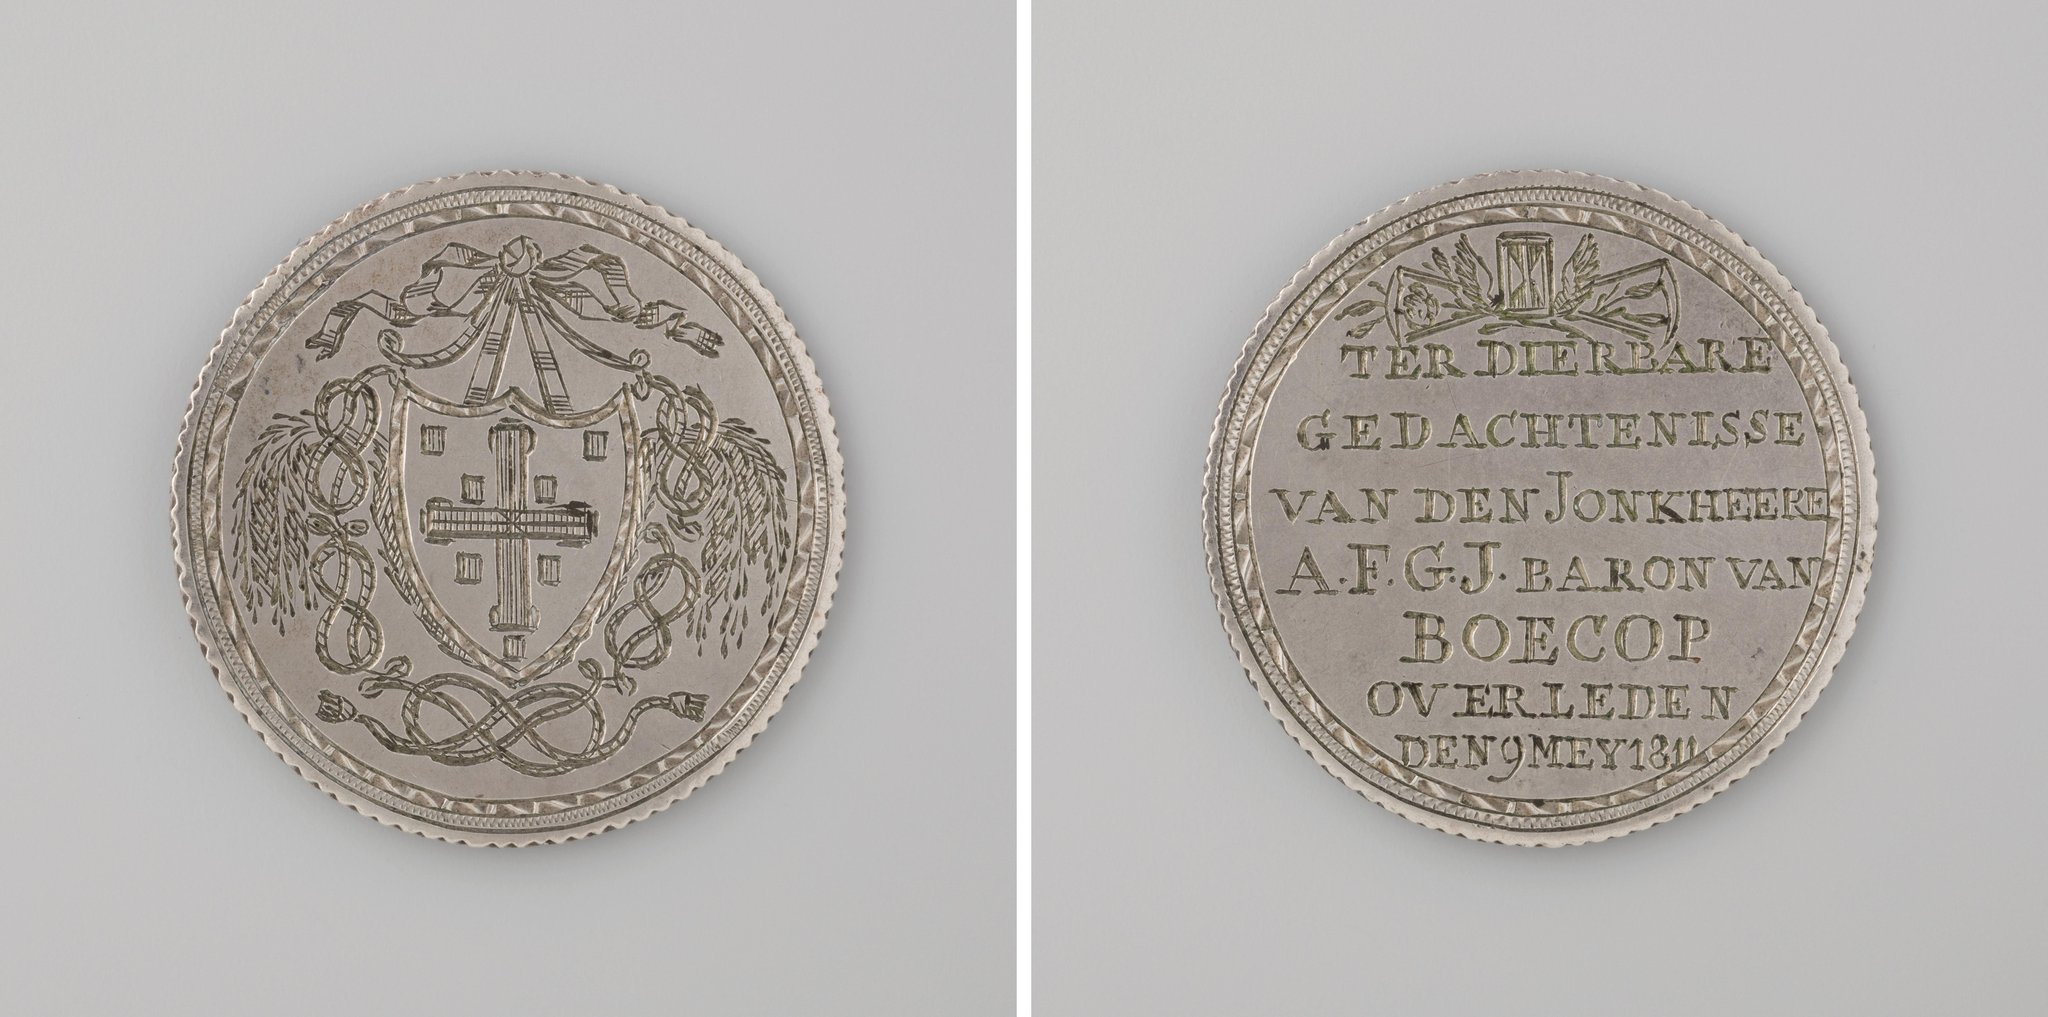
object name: overlijdenspenning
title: Overlijden van jonkheer Arend Frederik Godert Jan, baron van Boecop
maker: Anonymous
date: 1811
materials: silver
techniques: engraving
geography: netherlands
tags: arend frederik godert jan baron boecop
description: Zilveren penning. Voorzijde: wapenschild hangend aan lint omringd door geknoopt touw en treurwilgtakken. Keerzijde: opschrift onder gevleugelde zandloper op twee gekruiste zeisen